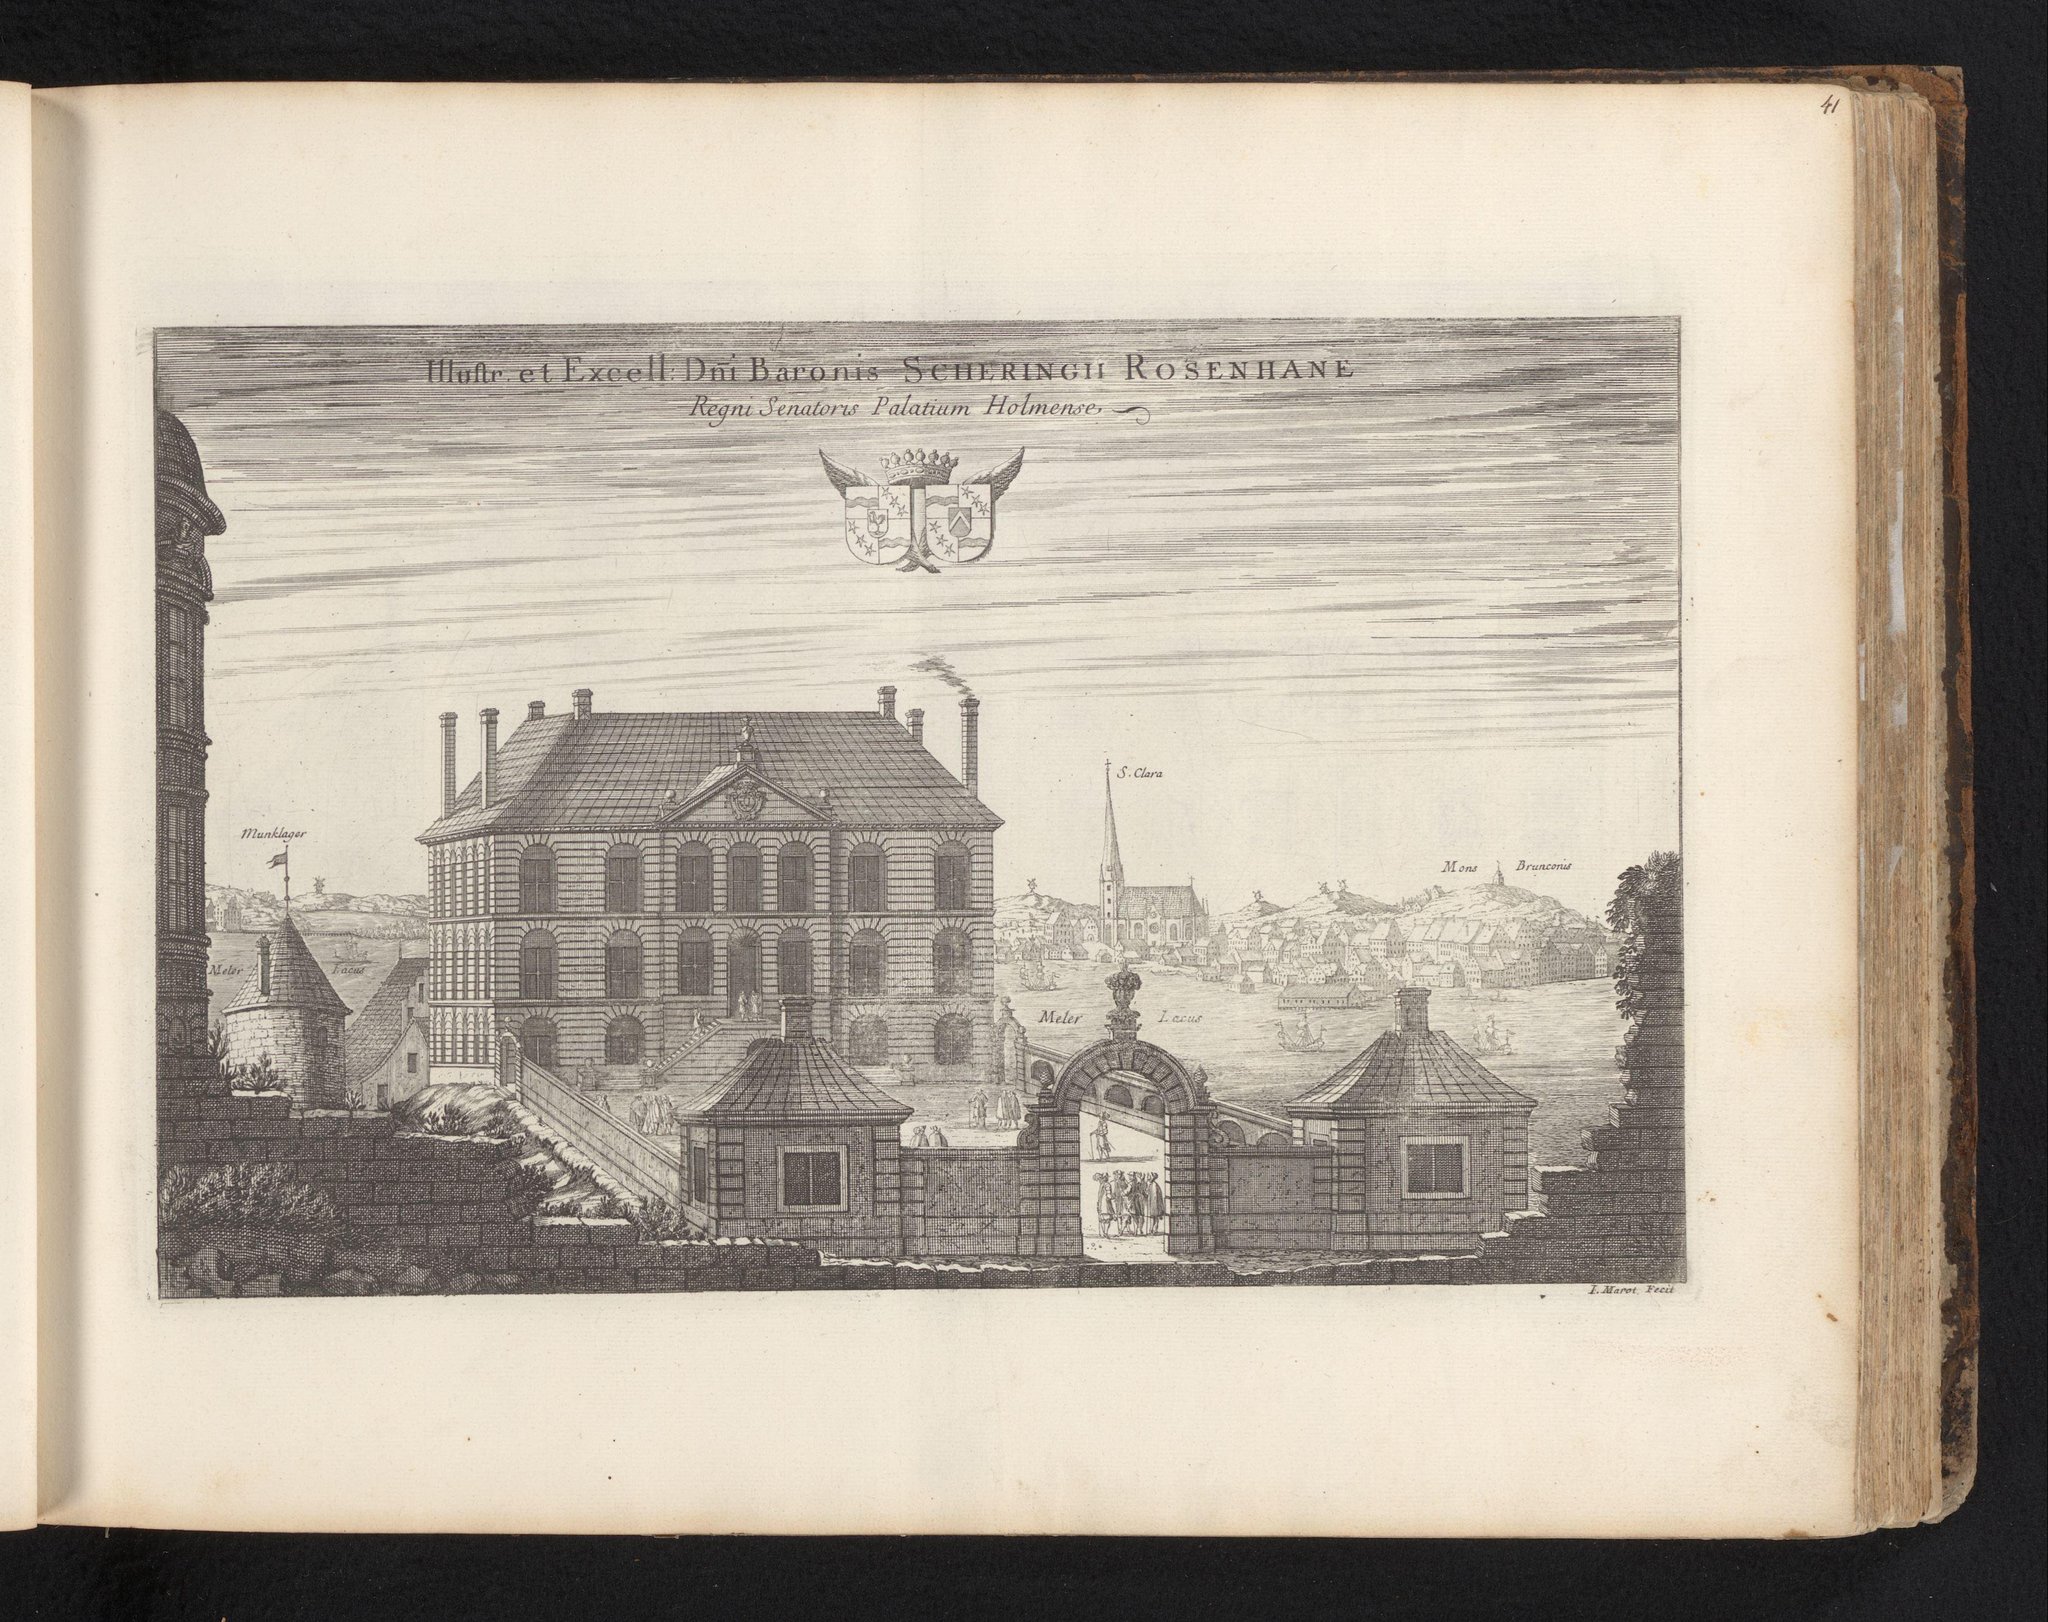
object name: album leaf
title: Paleis van Schering Rosenhane in Stockholm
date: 1670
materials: paper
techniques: etching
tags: palace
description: Kungliga Biblioteket, 'Suecia': http://www.kb.se/samlingarna/Kartor-bilder/Suecia-antiqua/ (geraadpleegd november 2016).